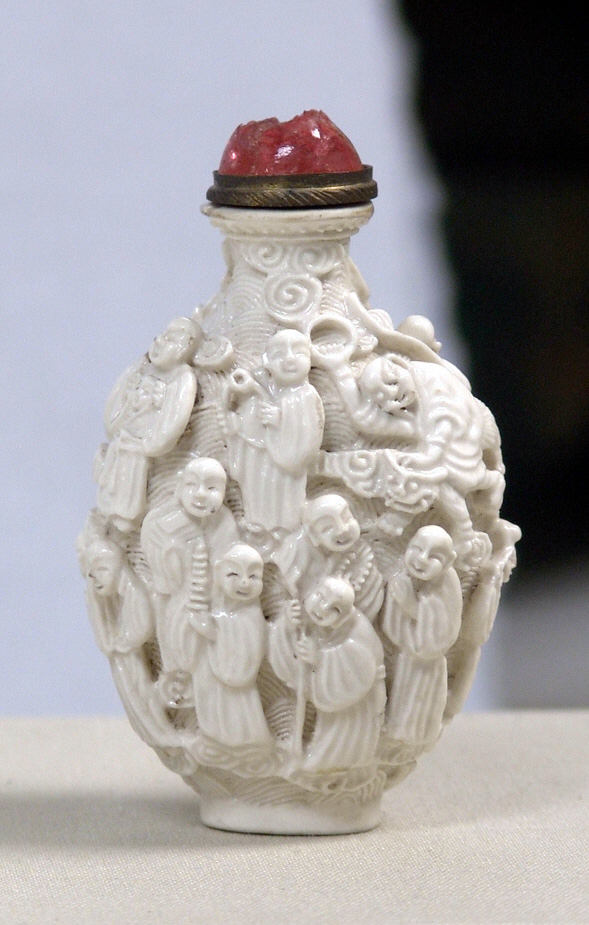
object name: snuff bottle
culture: chinese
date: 1796-1820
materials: porcelain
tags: human figures